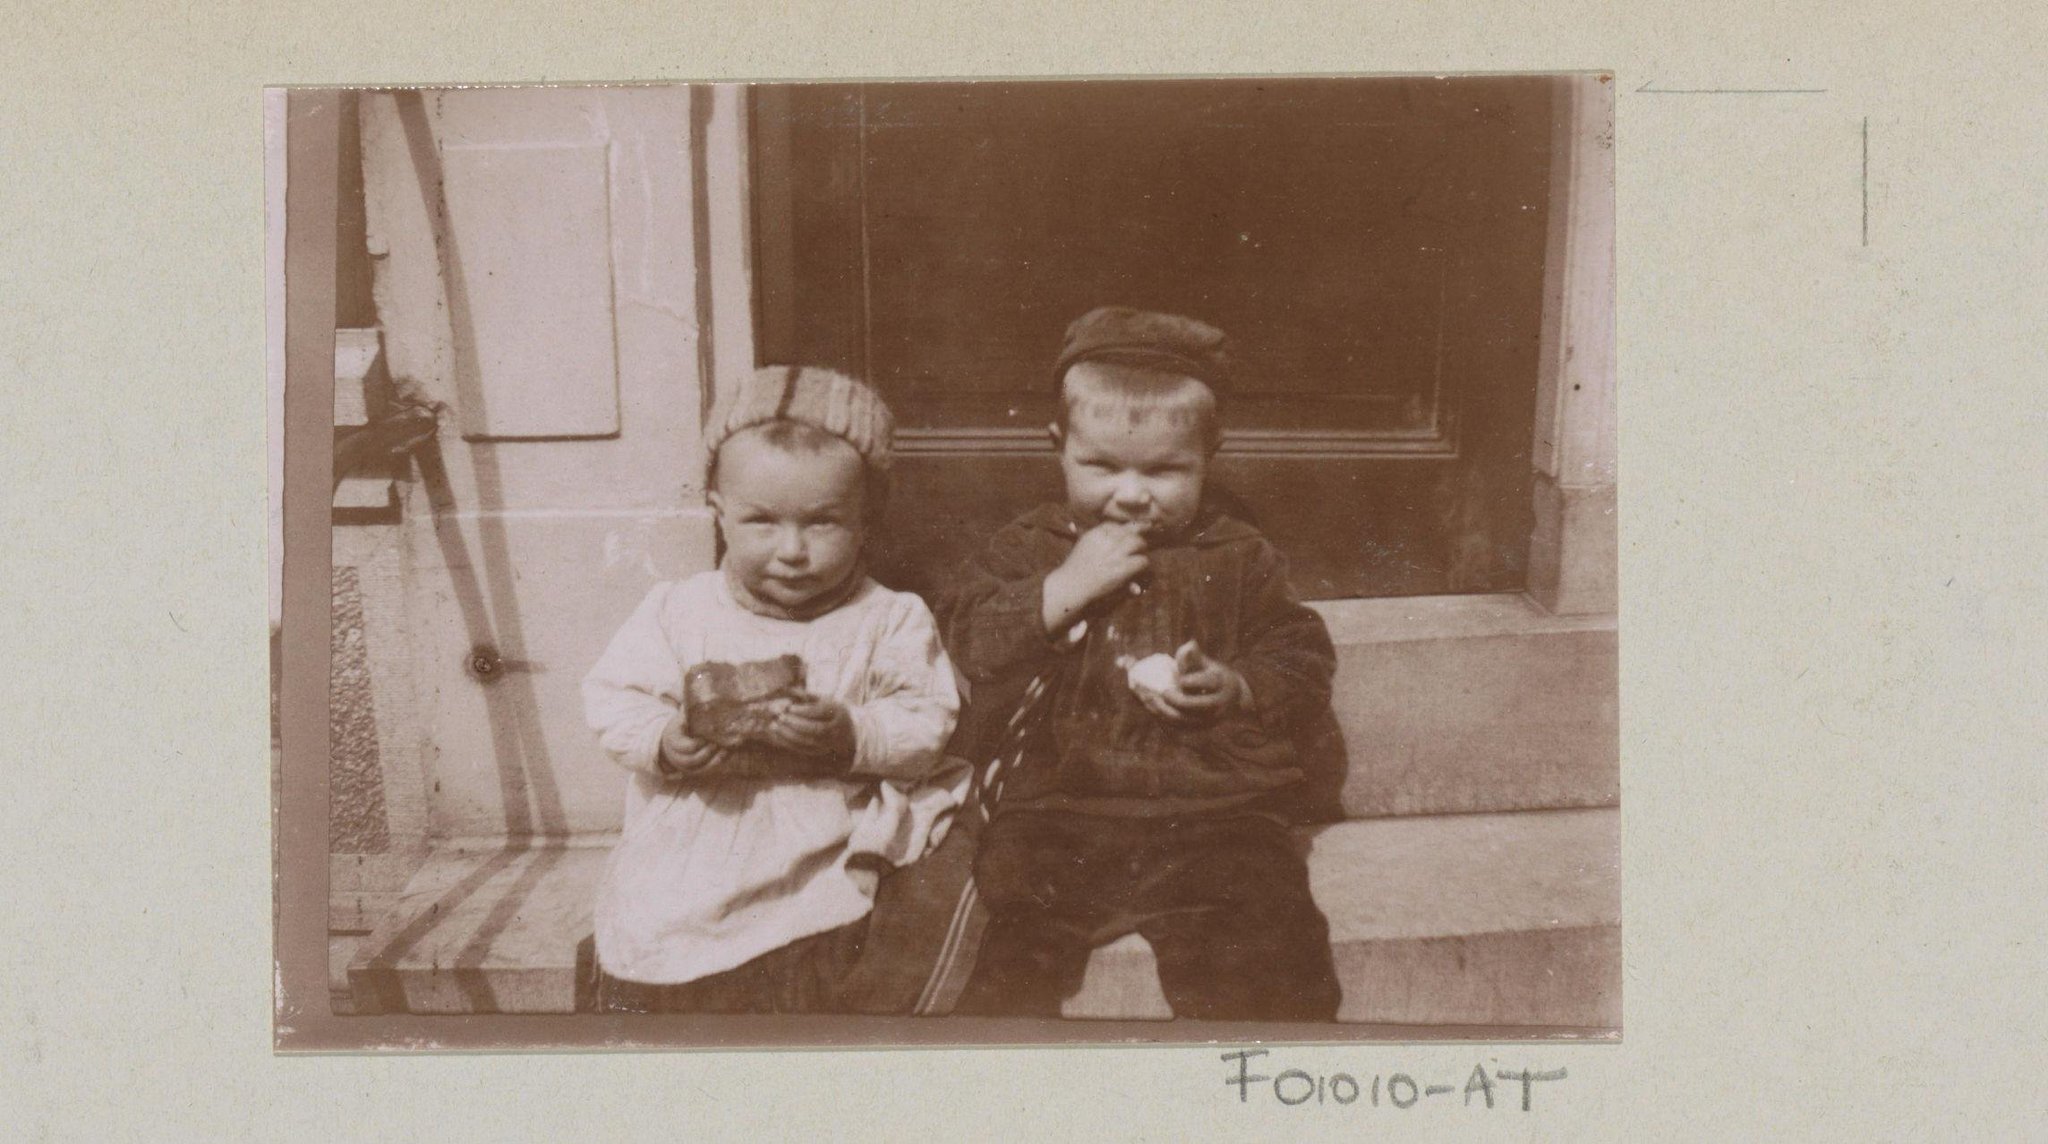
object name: photograph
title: Twee kinderen zittend op een stoep met boterhammen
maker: Anonymous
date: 1900-1910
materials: photographic support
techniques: collodion silver print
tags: filled breads, rolls, e.g. sandwich, hamburger, eating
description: Onderdeel van Familiealbum met onder meer foto's van Wijnhandel Kraaij & Co. Bordeaux-Amsterdam.